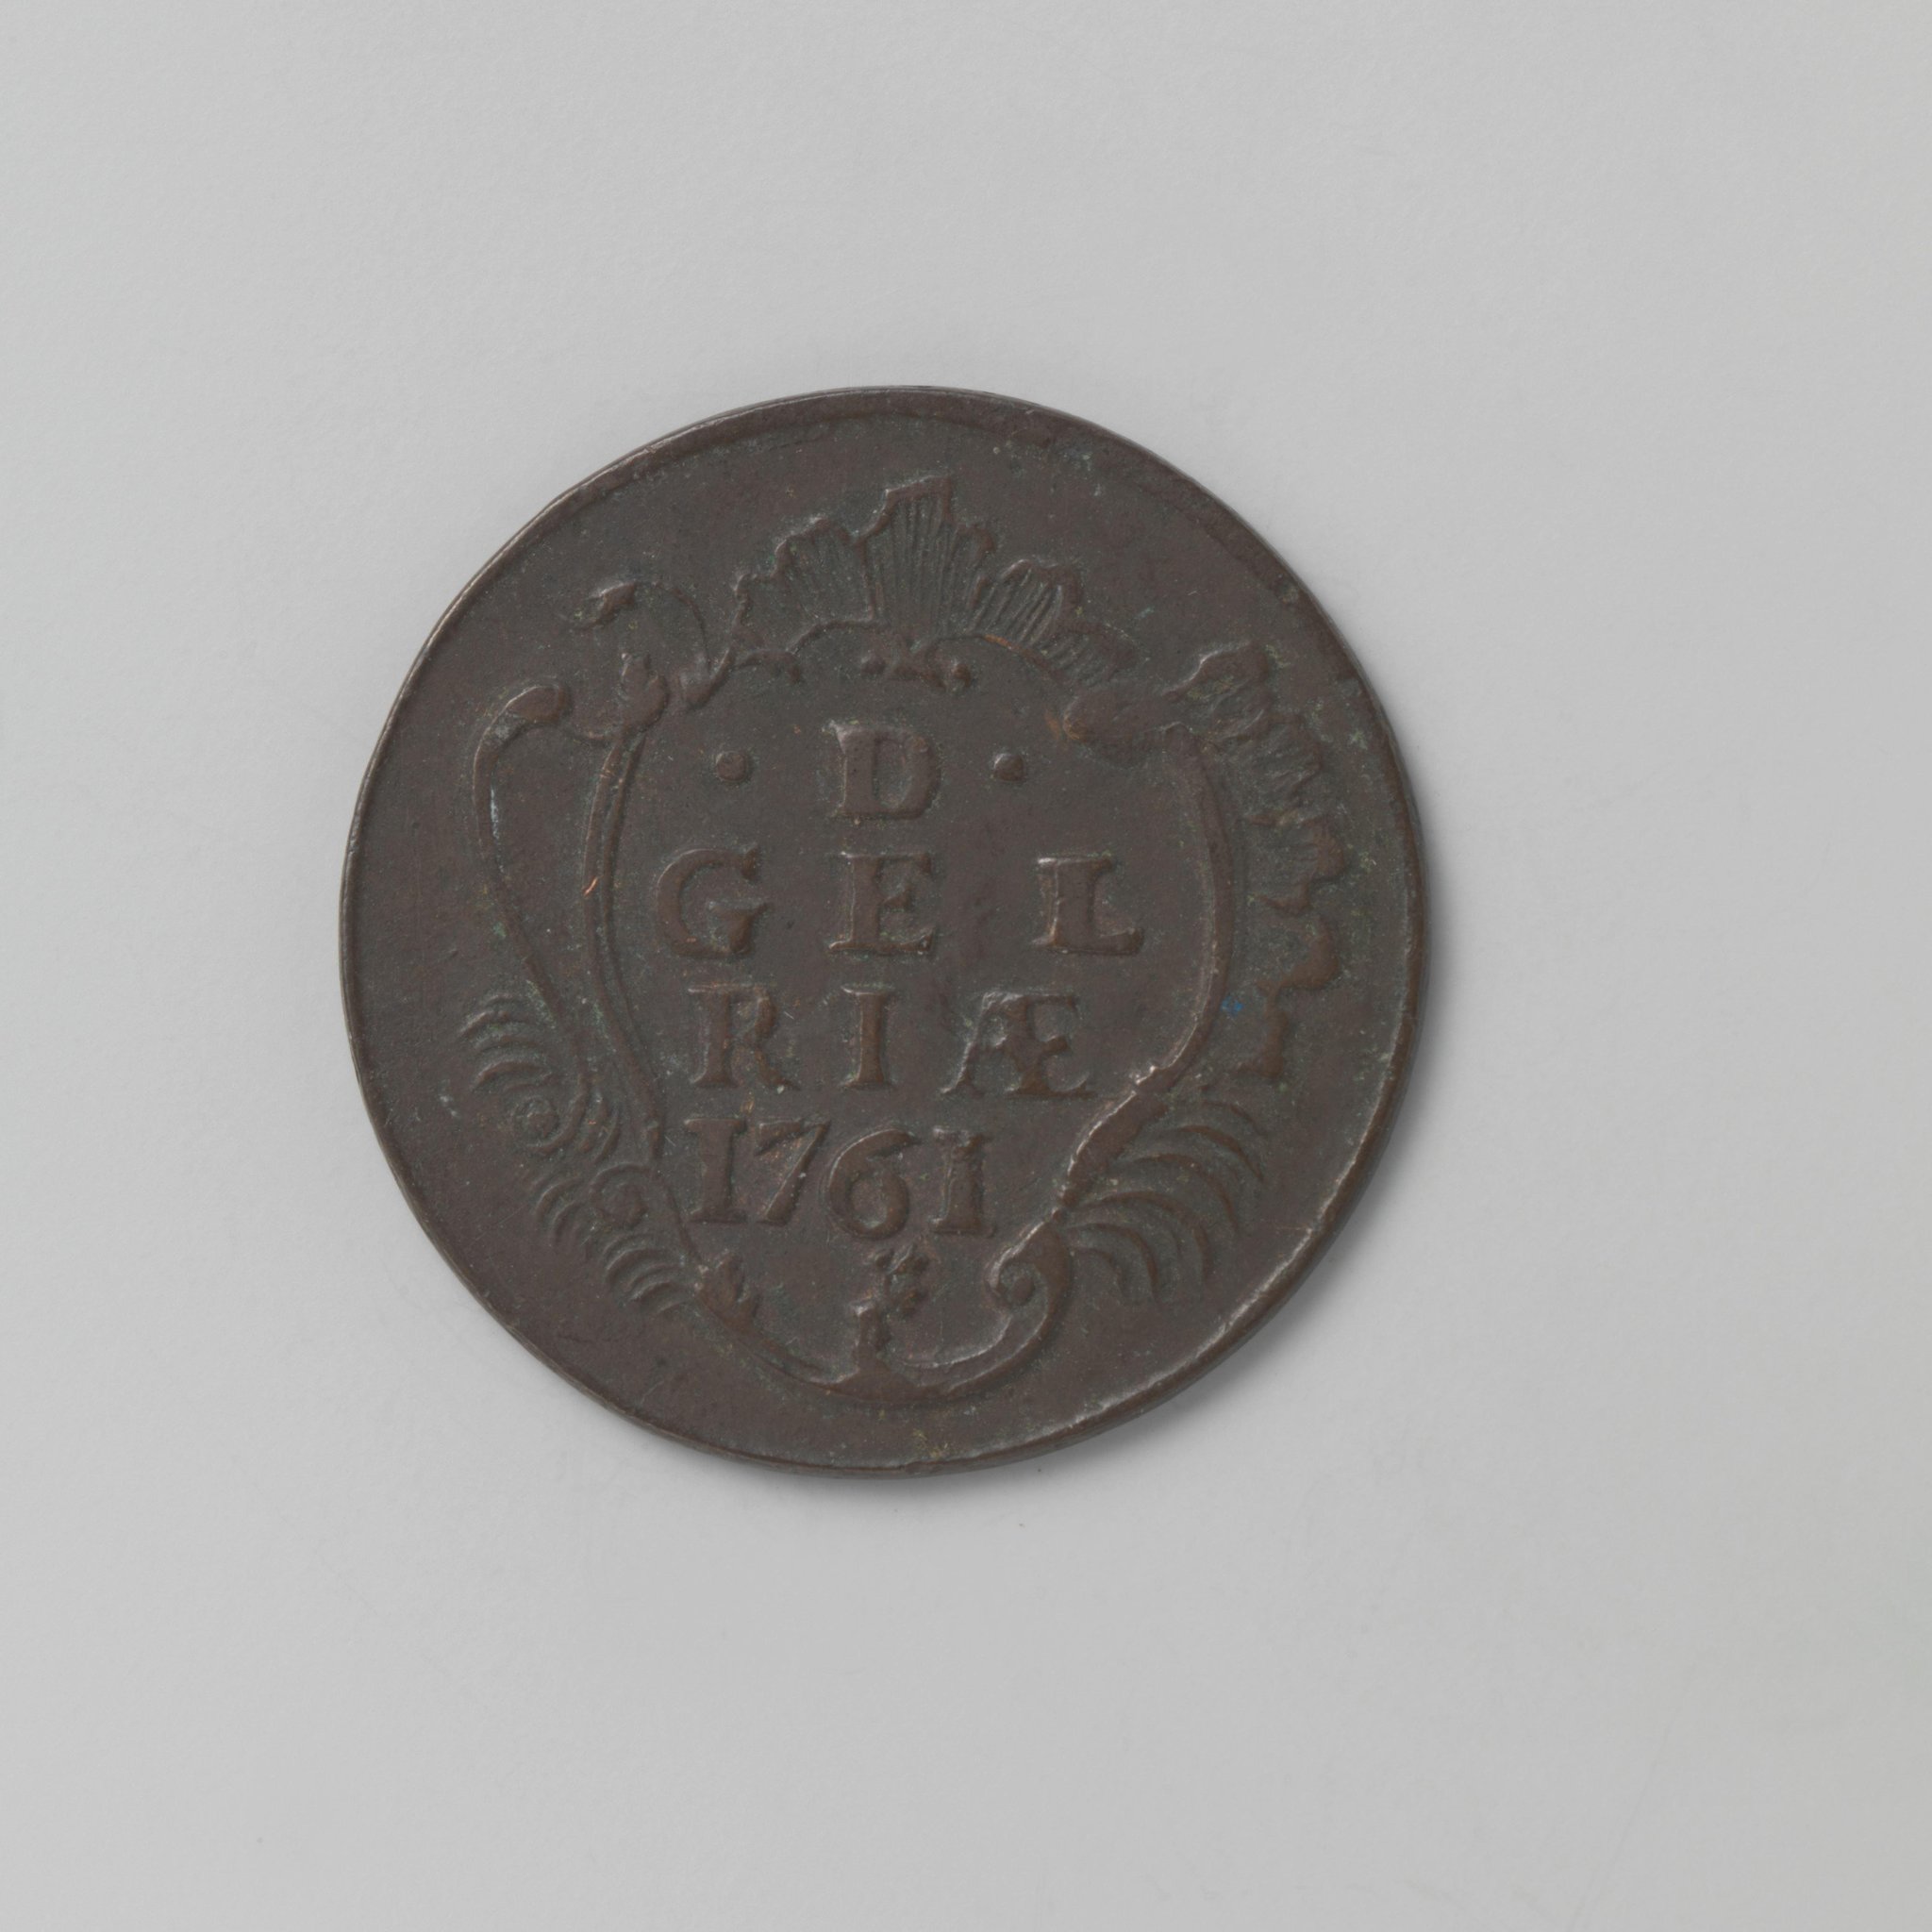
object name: duit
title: Gelderse duit, 1761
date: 1761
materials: copper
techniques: striking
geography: harderwijk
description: Koperen munt. Voorzijde: binnen weelderige rococo-versiering in drie regels D/GEL/RIAE, daaronder jaartal en muntmeesterteken. Keerzijde: gekroond Gelders wapenschild.